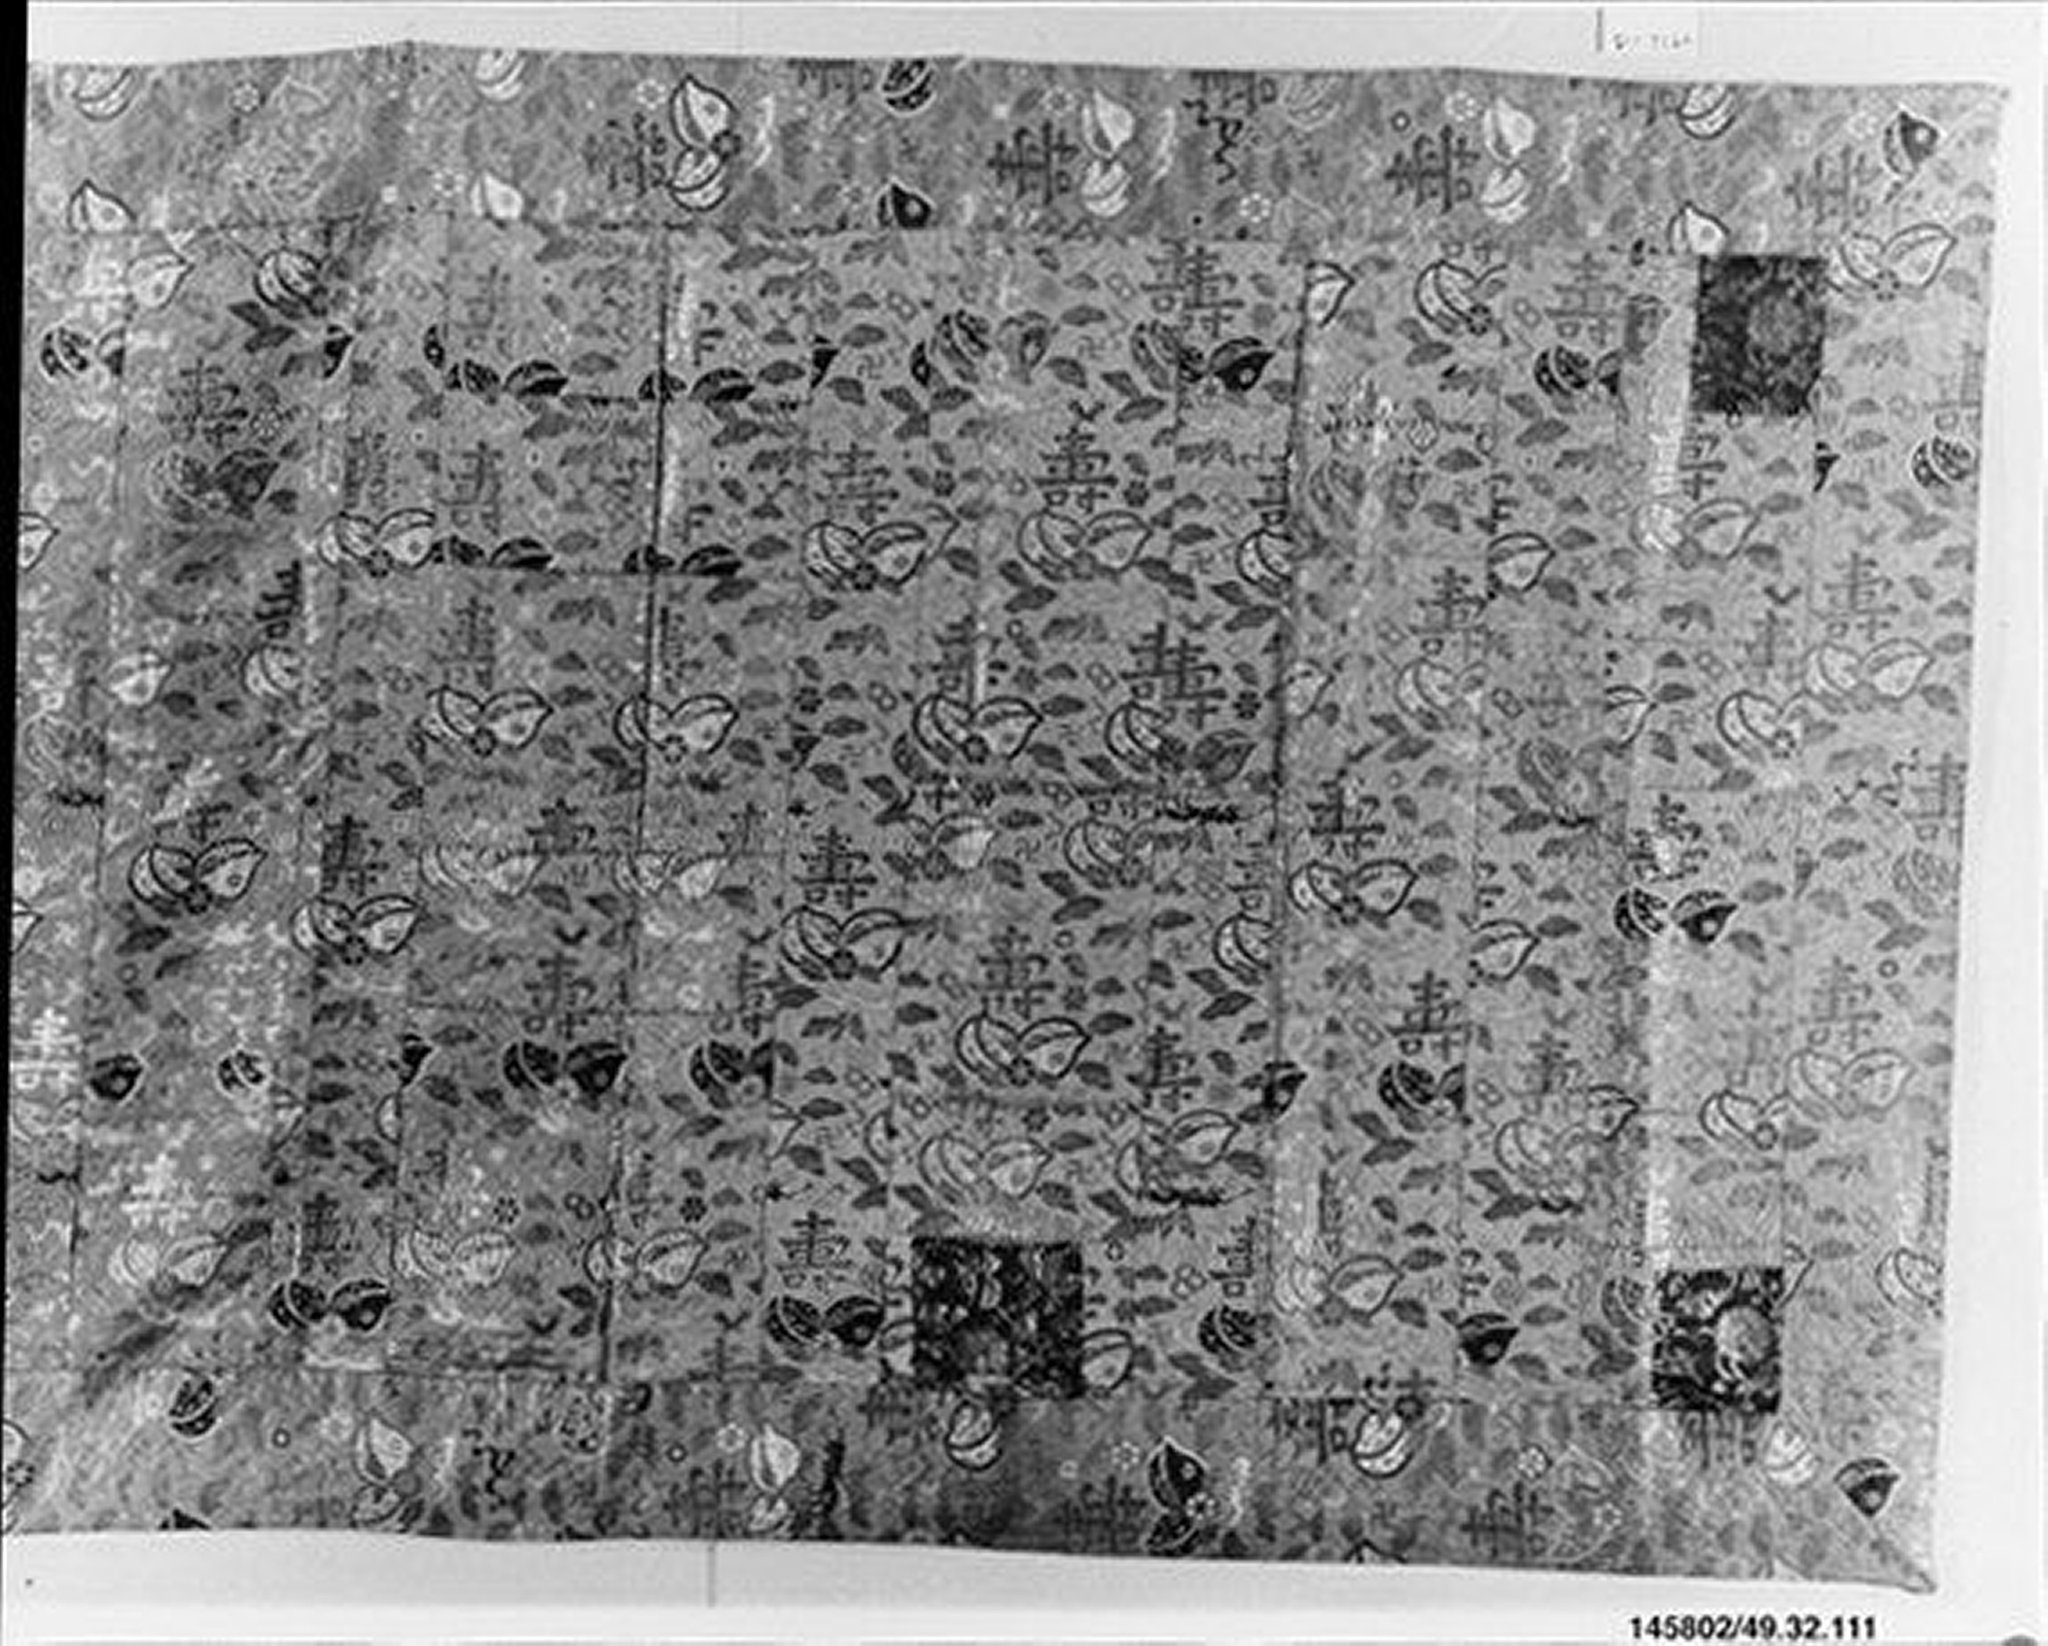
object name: robe, priest's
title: Priest's Robe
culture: japanese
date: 1701-1733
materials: metal thread, silk